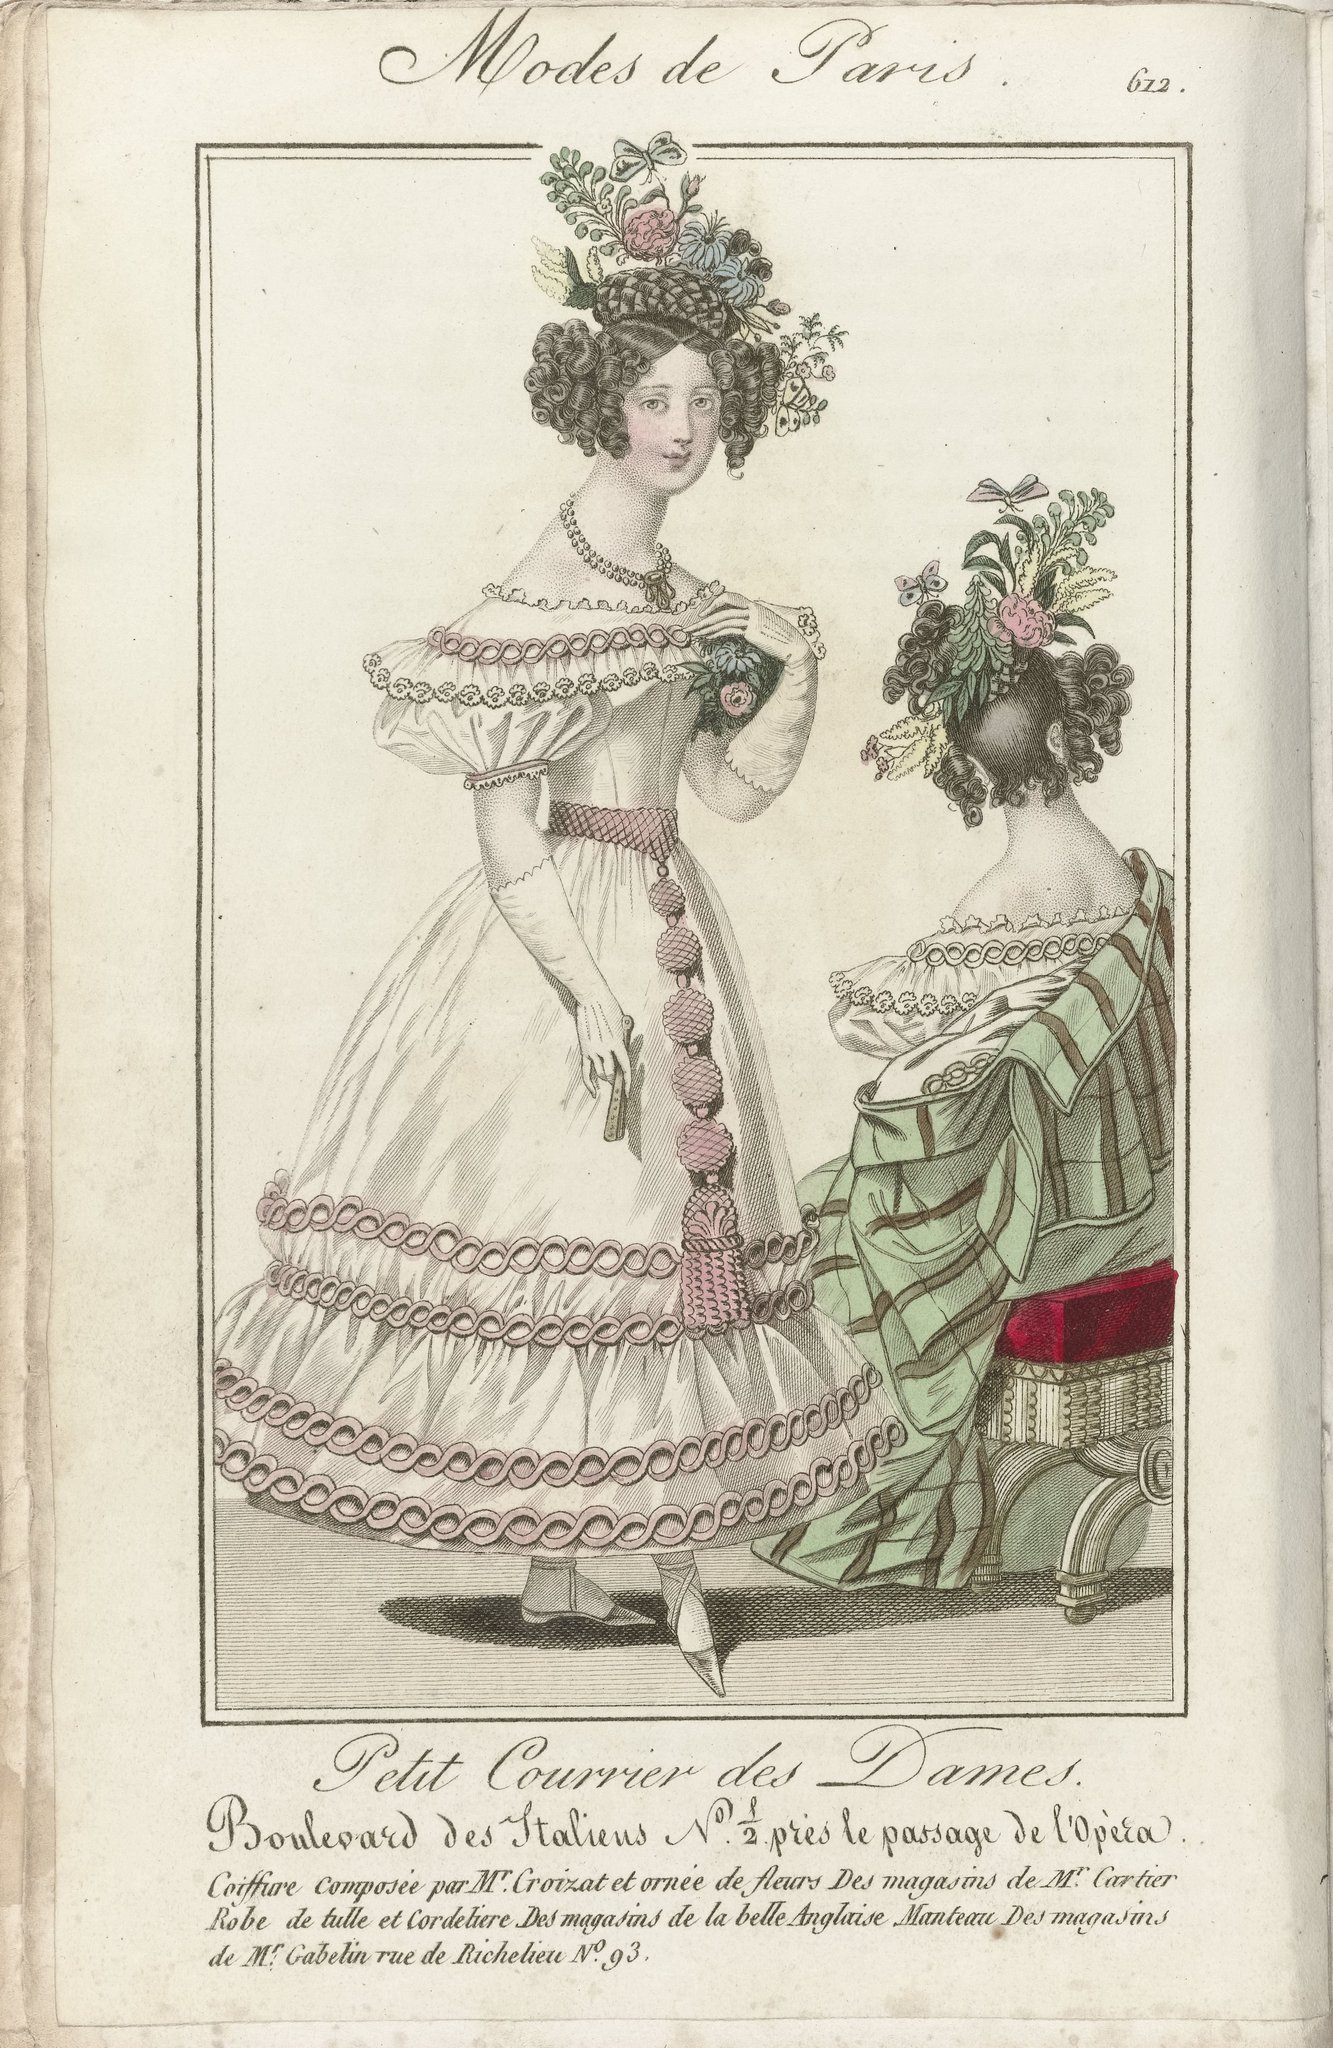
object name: fashion print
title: Petit Courrier des Dames, 1829 (612)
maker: Anonymous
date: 1829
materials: paper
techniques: engraving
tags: fashion plates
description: Prent uit het modetijdschrift Petit Courrier des Dames (1821-1868).